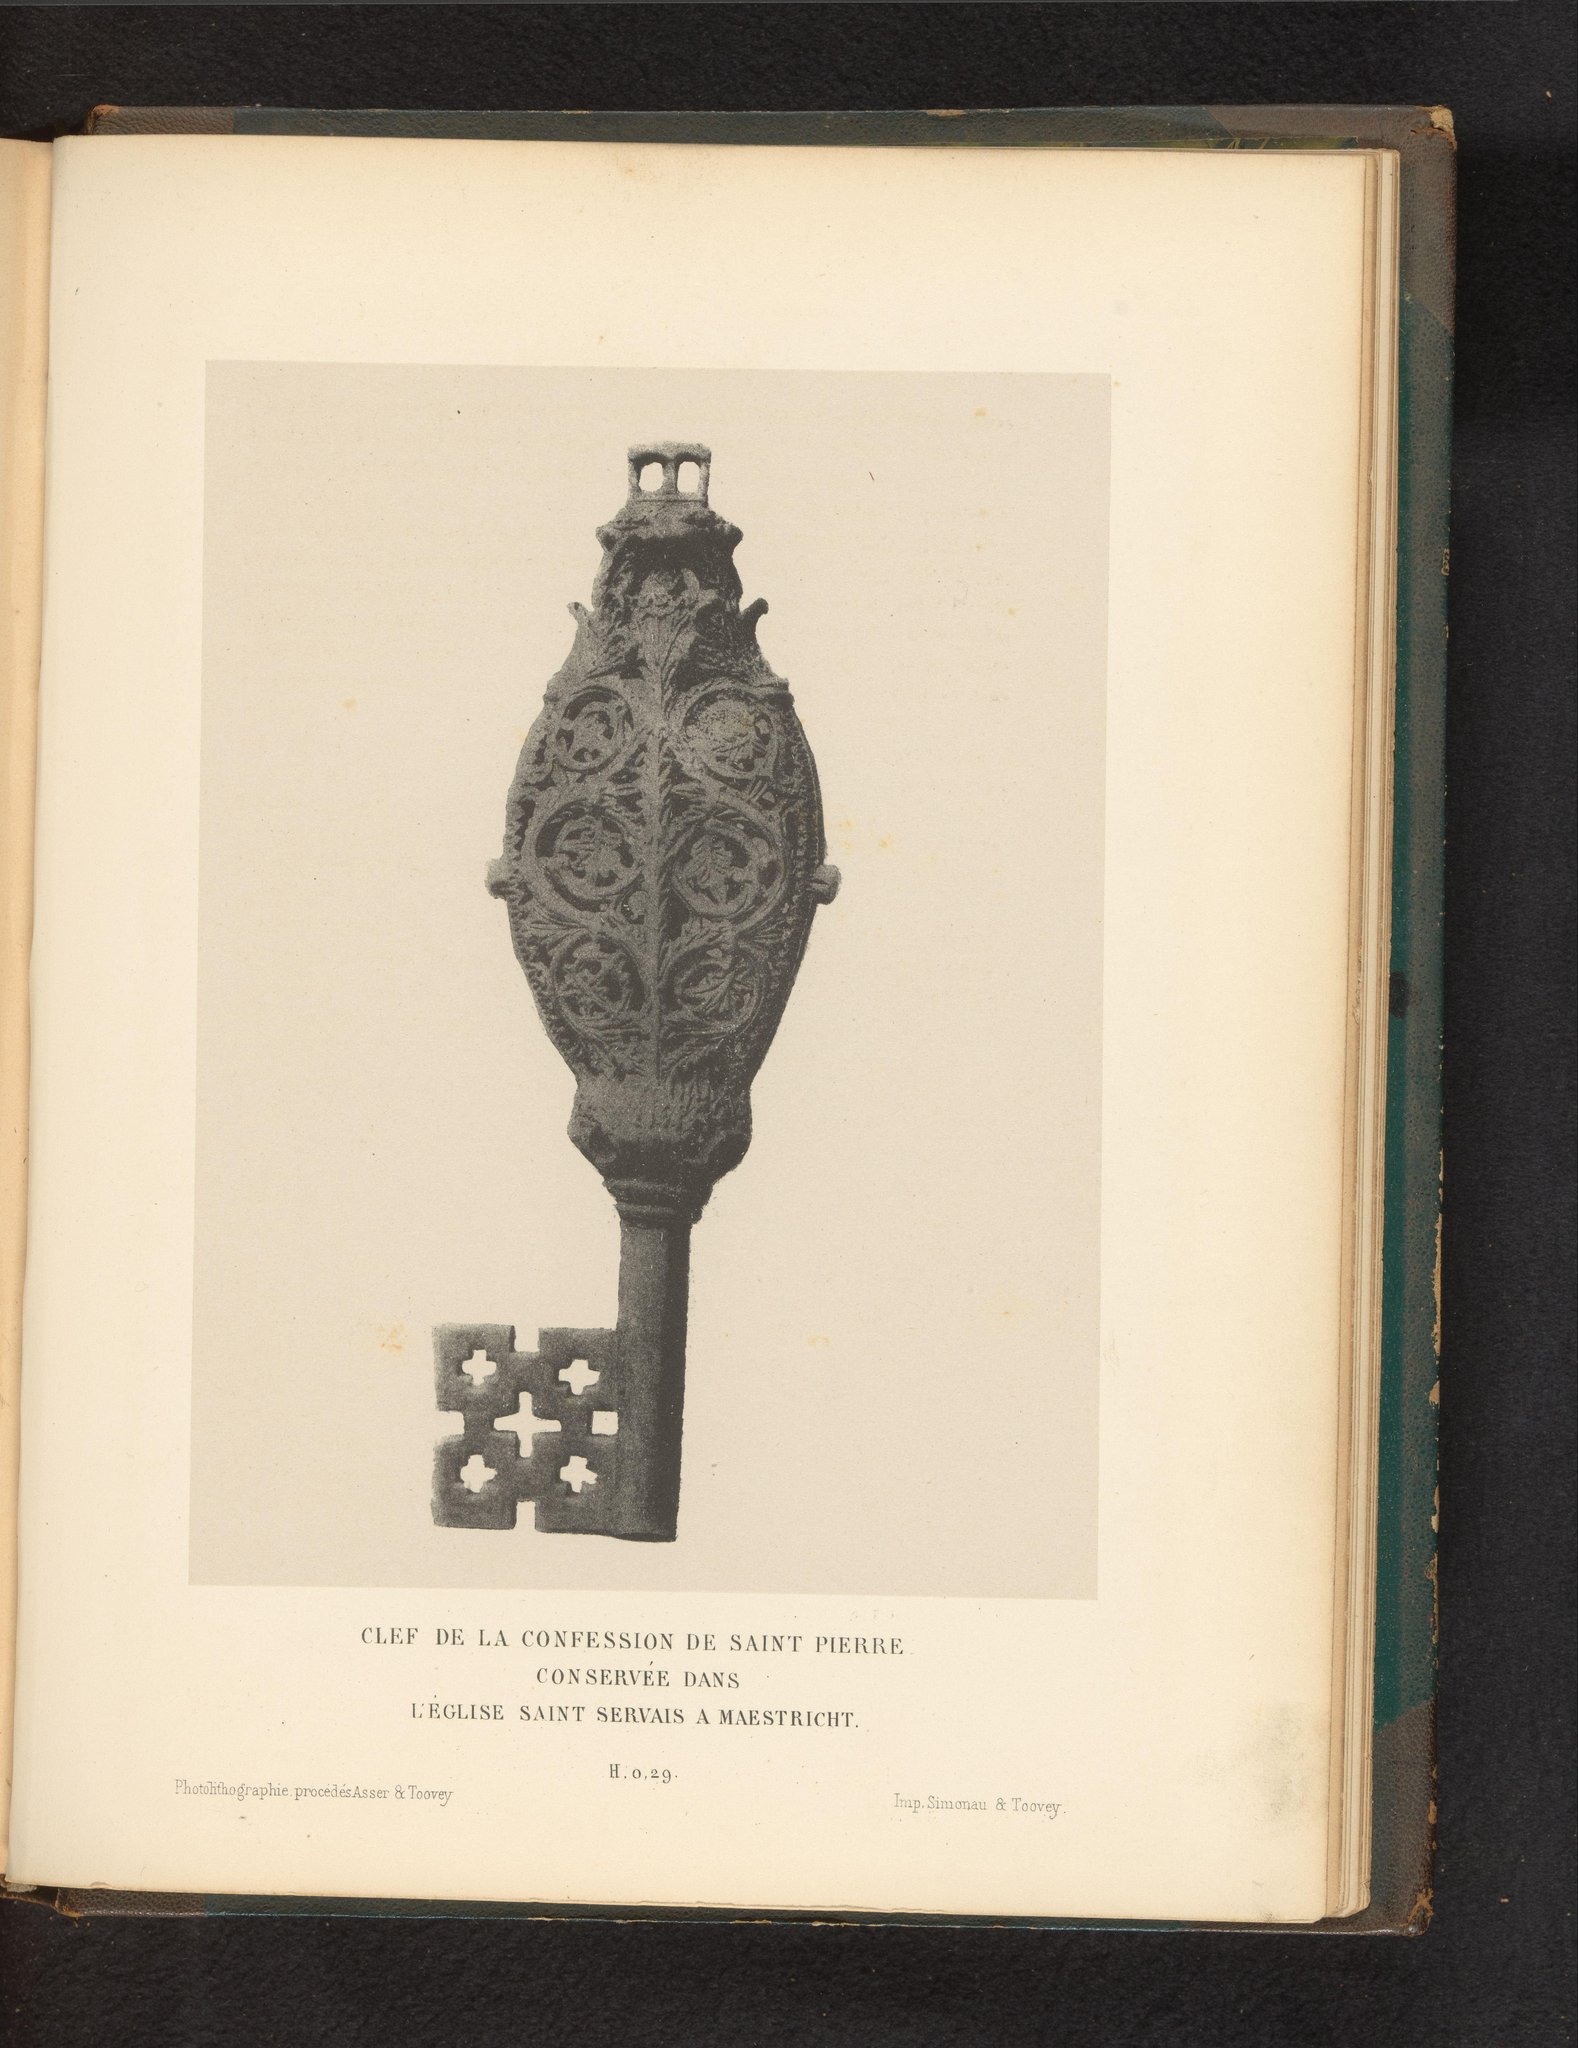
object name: page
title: Sleutel van de heilige Petrus uit de Sint-Servaasbasiliek in Maastricht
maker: Anonymous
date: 1860-1865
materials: paper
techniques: photolithography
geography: brussels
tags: key, the apostle peter, first bishop of rome; possible attributes: book, cock, (upturned) cross, (triple) crozier, fish, key, scroll, ship, tiara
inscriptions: inscription: ‘H.0,29.’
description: Prent tegenover pagina 336 van het tweede deel.